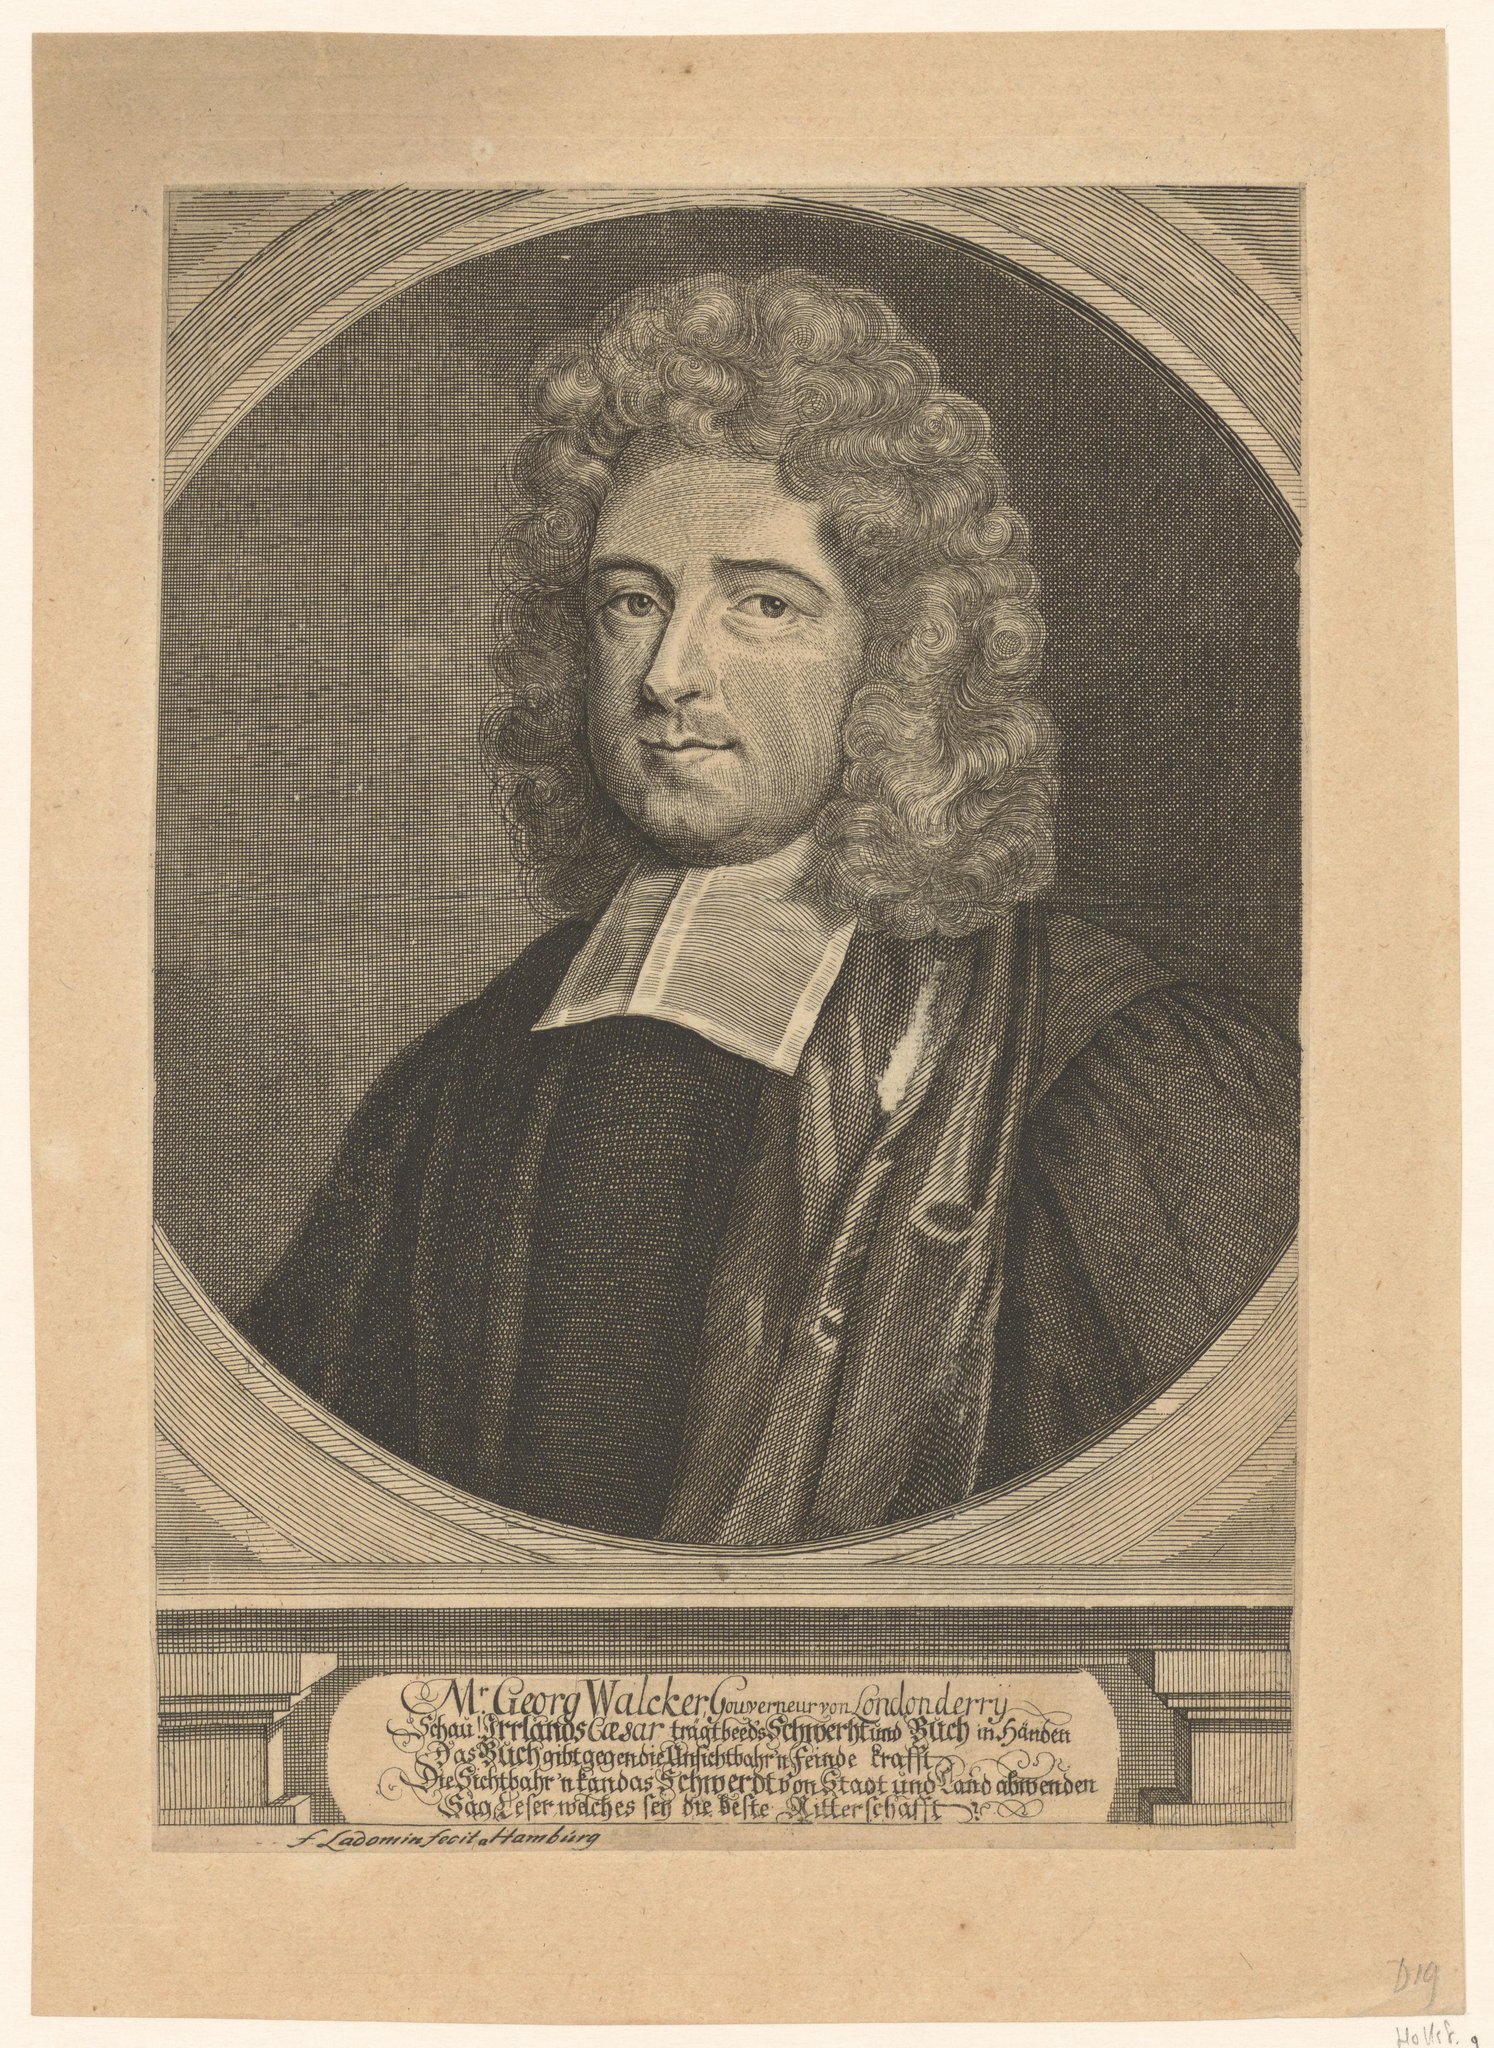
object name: print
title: Portret van George Walker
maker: franciscus ladomin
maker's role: print maker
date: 1688-1690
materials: paper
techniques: engraving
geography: hamburg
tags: george walker, theologian, historical persons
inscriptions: collector's mark: Lugt 2228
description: Tekst in het Duits in de omlijsting en op de sokkel.